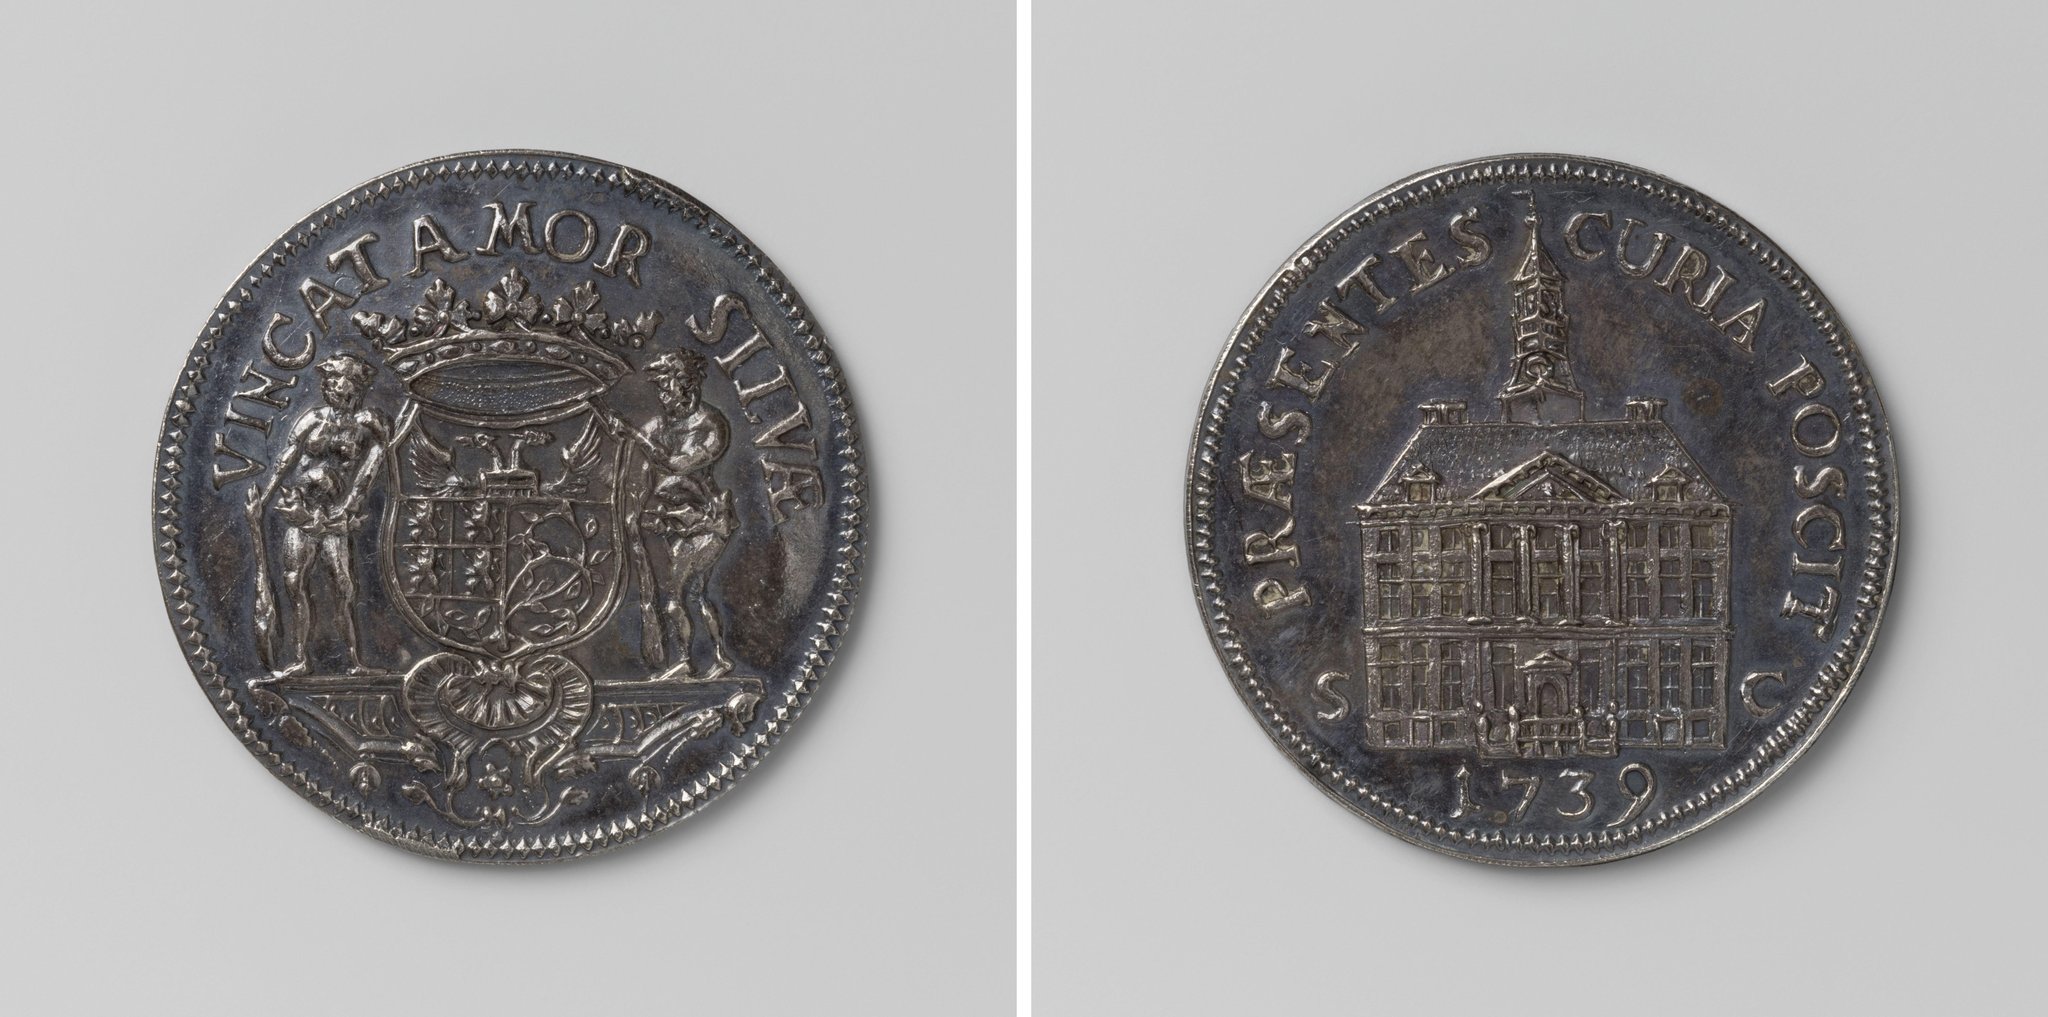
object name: council medal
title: Vroedschapspenning van de stad 's-Hertogenbosch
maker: theodorus everardus van berckel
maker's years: 1708-1770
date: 1739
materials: silver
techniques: striking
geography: den bosch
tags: den bosch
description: Zilveren penning. Voorzijde: gekroond wapenschild, geflankeerd door twee wildemannen met knots over schouder, staande op voetstuk binnen omschrift. Keerzijde: stadhuis tussen monogram van de letters boven jaartal binnen omschrift.